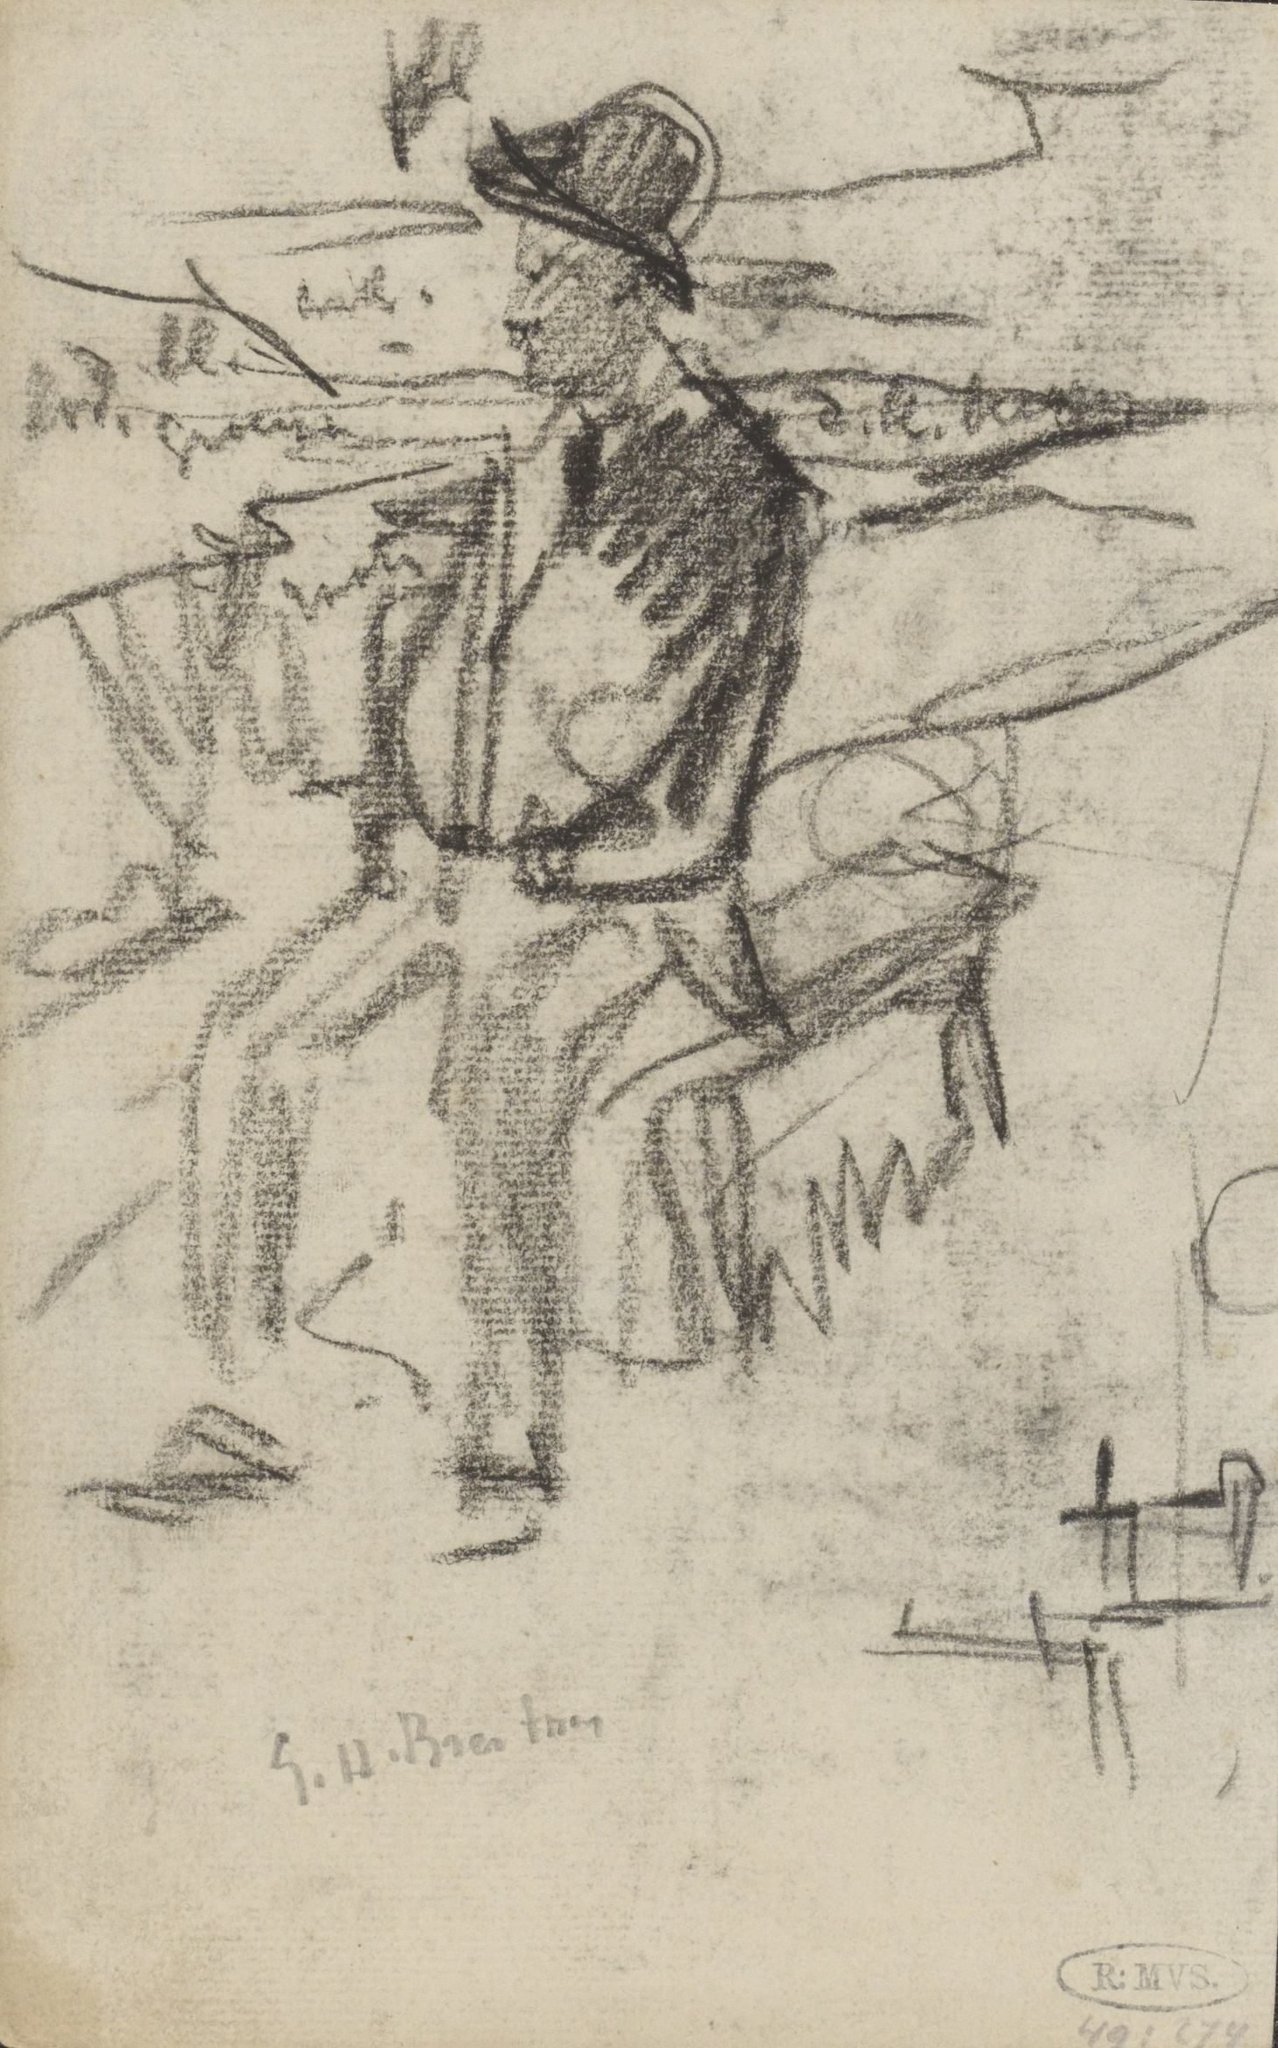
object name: drawing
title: Man op een bank in een landschap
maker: george hendrik breitner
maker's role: draughtsman, painter, print maker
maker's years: 1857-1923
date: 1873-1886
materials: chalk, paper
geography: the hague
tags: adult man (+ sitting), walking-stick, staff, landscapes in the temperate zone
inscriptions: collector's mark: Lugt 2228, signature: ‘G.H. Breitner’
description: Hij houdt een stok vast. Mogelijk een rustende wandelaar.